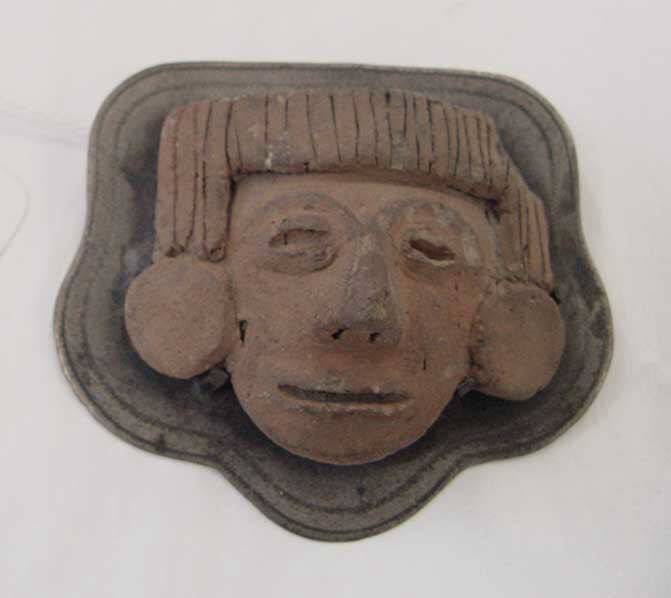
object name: pin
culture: indigenous american, olmec peoples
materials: clay, silver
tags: faces